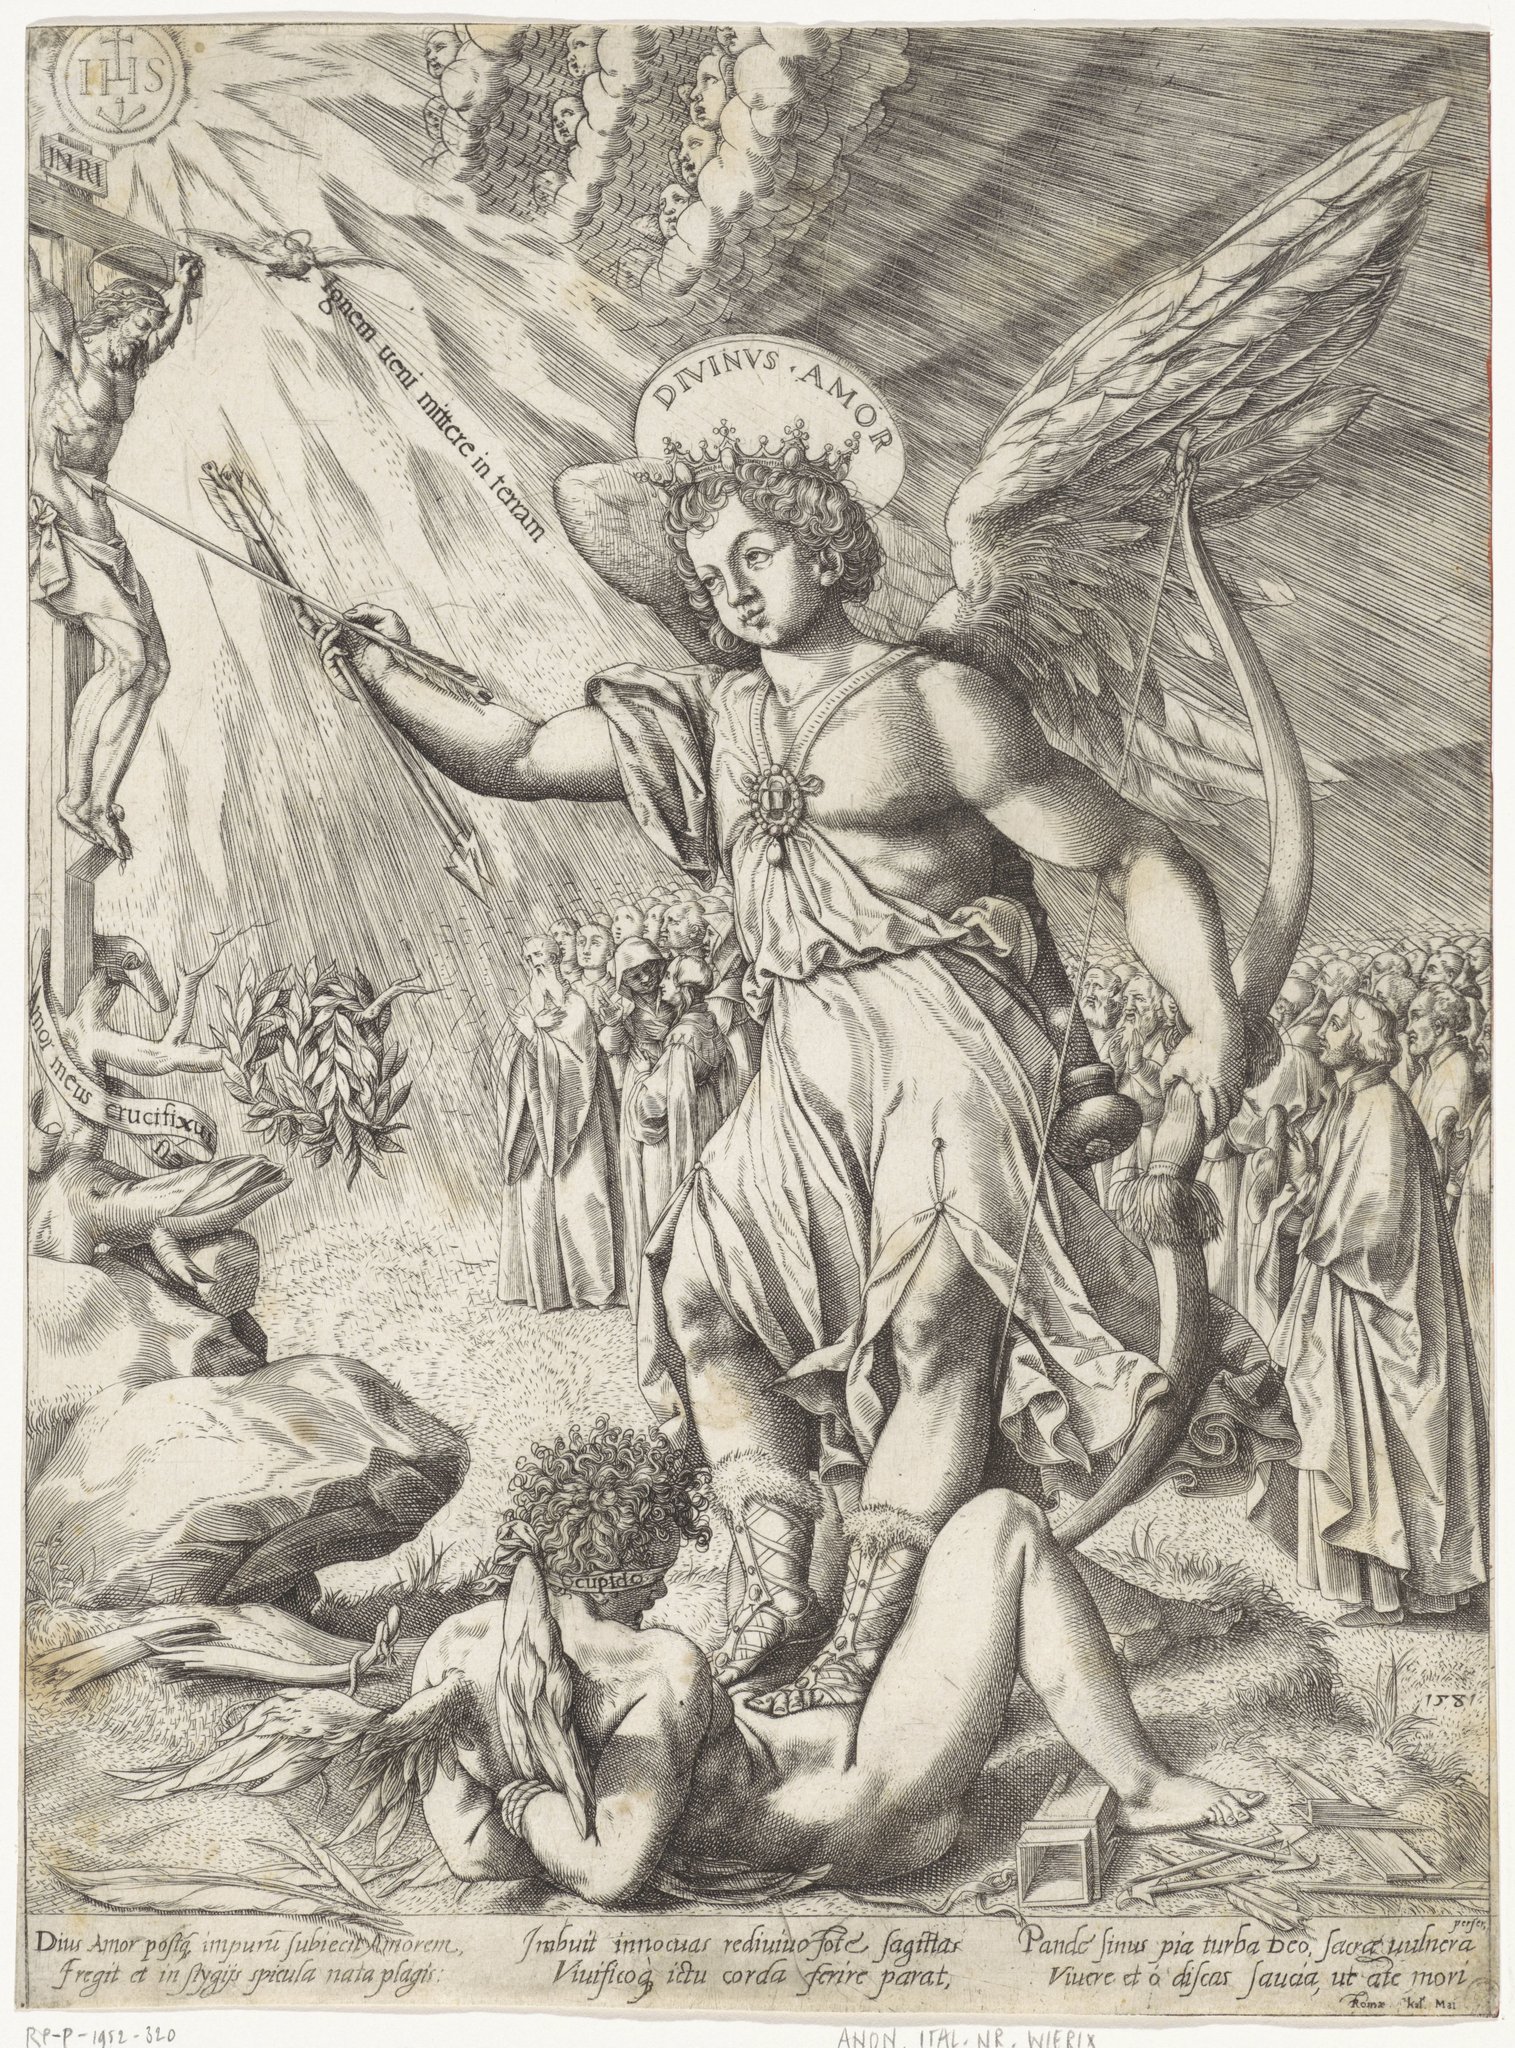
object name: print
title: Divinvs Amor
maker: Anonymous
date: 1581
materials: paper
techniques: engraving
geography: antwerp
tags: punishment of cupid, heavenly love versus earthly love, ihs ('iesus hominum salvator') ~ symbol of christ, holy ghost represented as a dove (in flames)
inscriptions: collector's mark: Lugt 2228, collector's mark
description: Een gekroonde engel, de personificatie van de hemelse liefde, vertrapt de geblinddoekte en vastgebonden Amor. De engel doopt zijn pijl in de kruiswond in Christus' zijde. Op de achtergrond een menigte gelovigen die opkijkt naar de duif van de Heilige Geest en het monogram van Christus aan de hemel. In de marge een zesregelig onderschrift, in drie kolommen, in het Latijn.